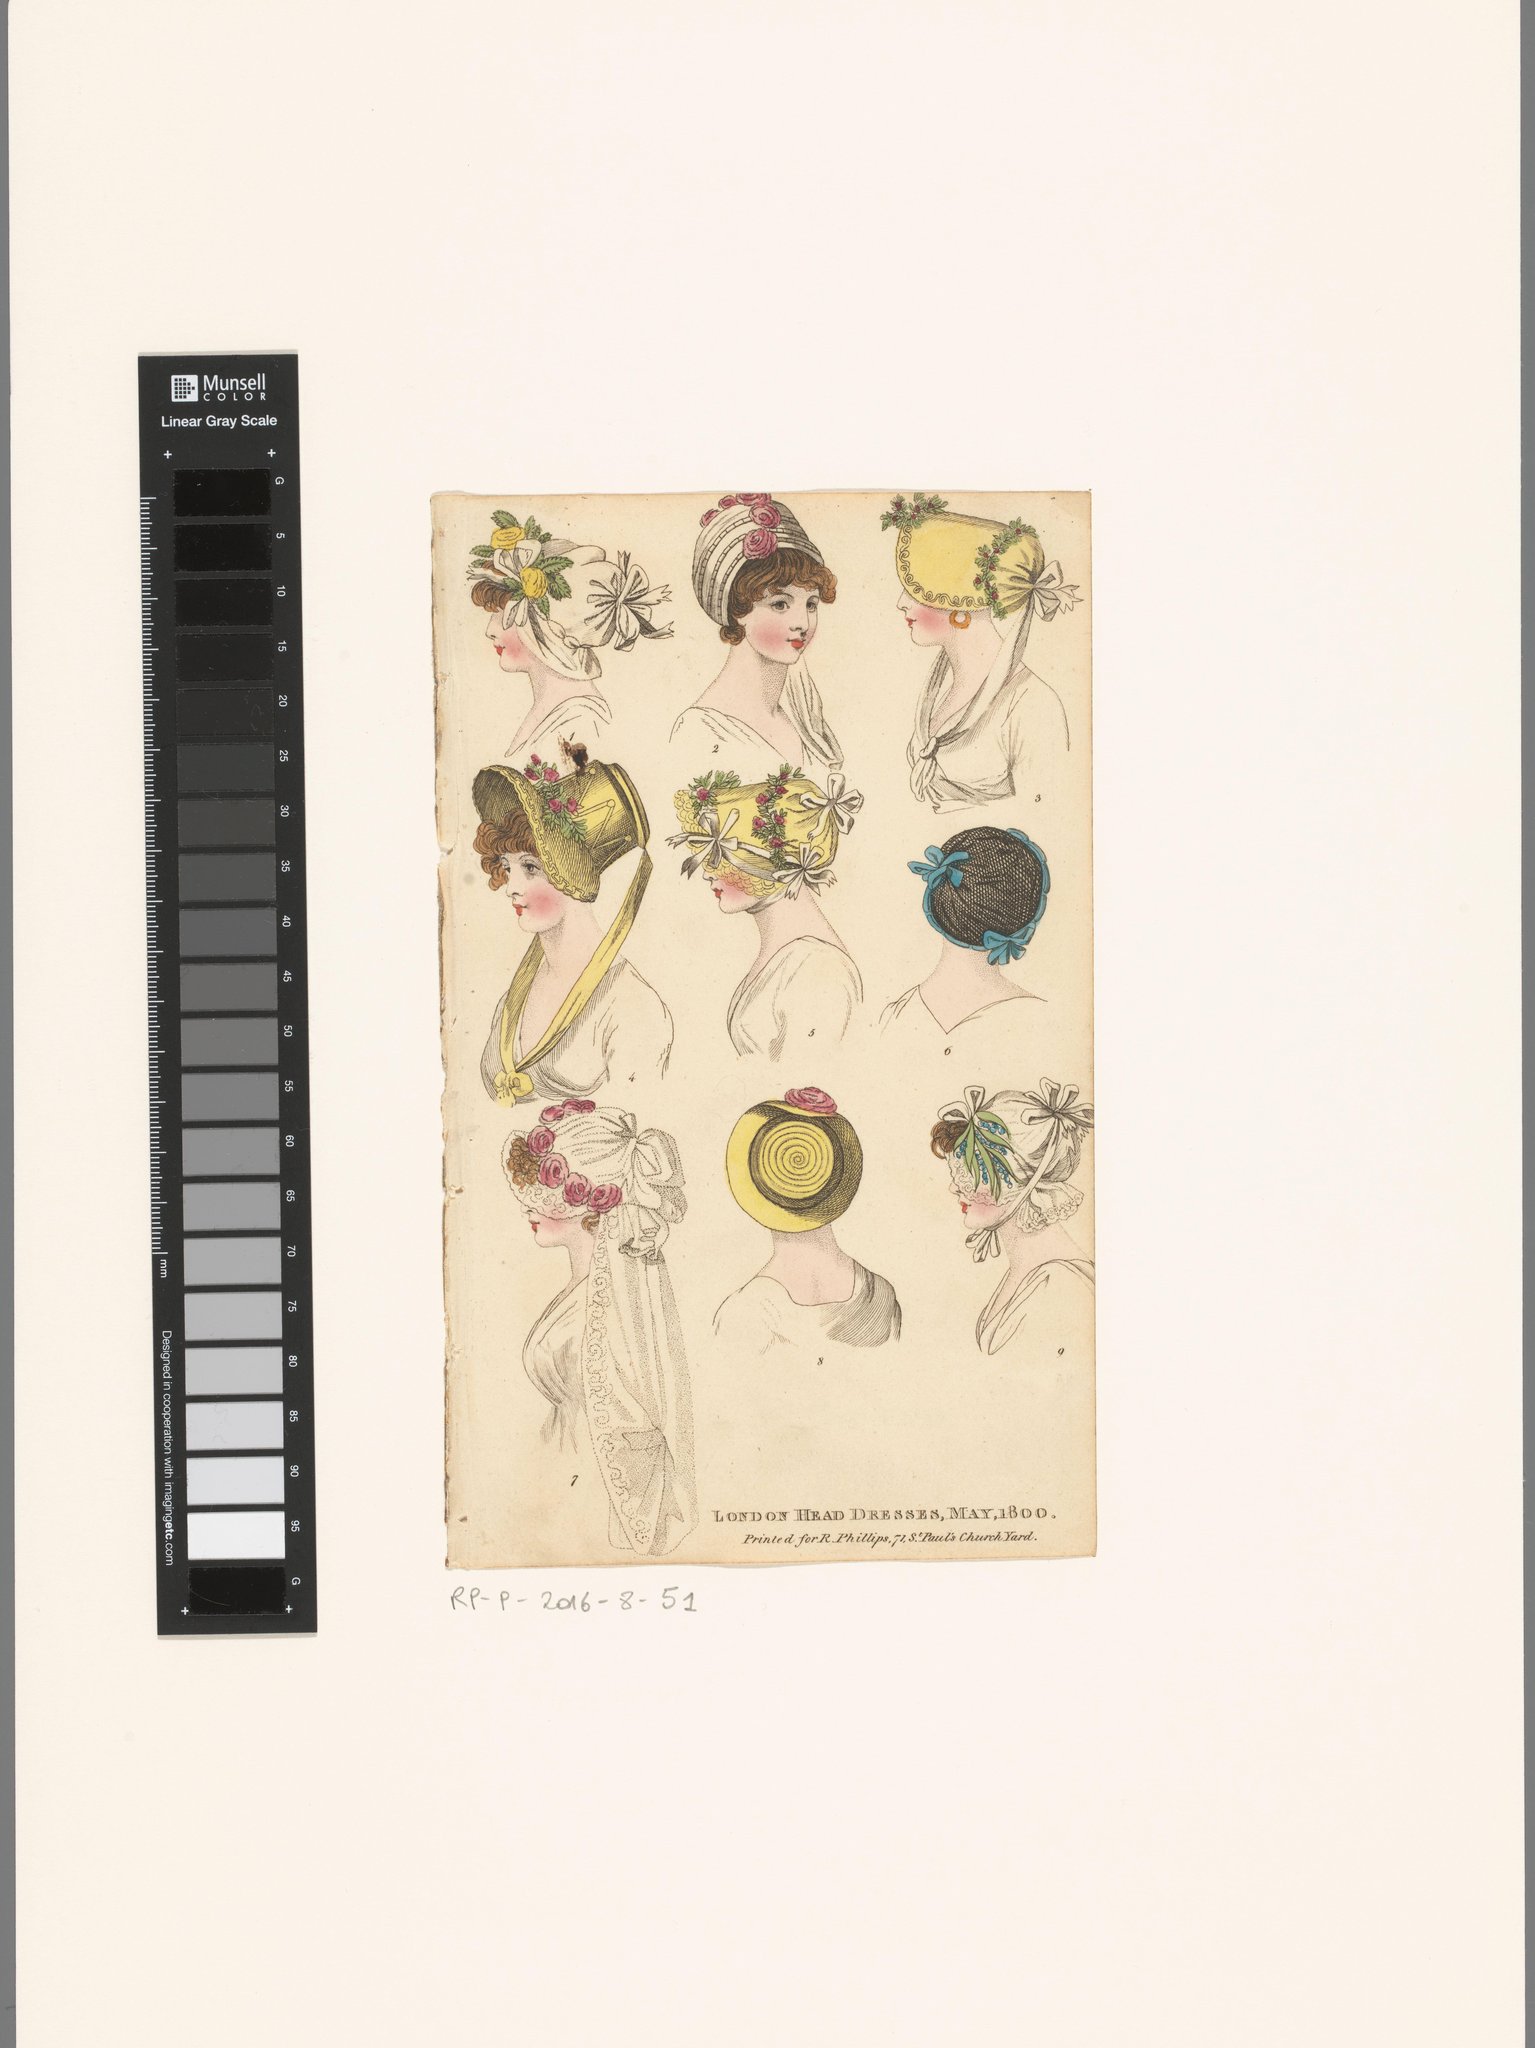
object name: fashion print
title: Magazine of Female Fashions of London and Paris: London Head Dresses, May, 1800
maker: richard phillips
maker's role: bookseller, publisher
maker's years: 1767-1840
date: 1800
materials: paper, ink, watercolor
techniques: engraving, etching, hand coloring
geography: london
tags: head-gear (straw hat) (+ women's clothes), head-gear: cap (+ women's clothes), fashion plates, head-gear: hat (+ women's clothes)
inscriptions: collector's mark: Lugt 2228, : ‘London head Dresses, May 1800’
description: Negen Engelse hoeden en mutsen voor vrouwen, van voren, opzij en van achteren gezien.